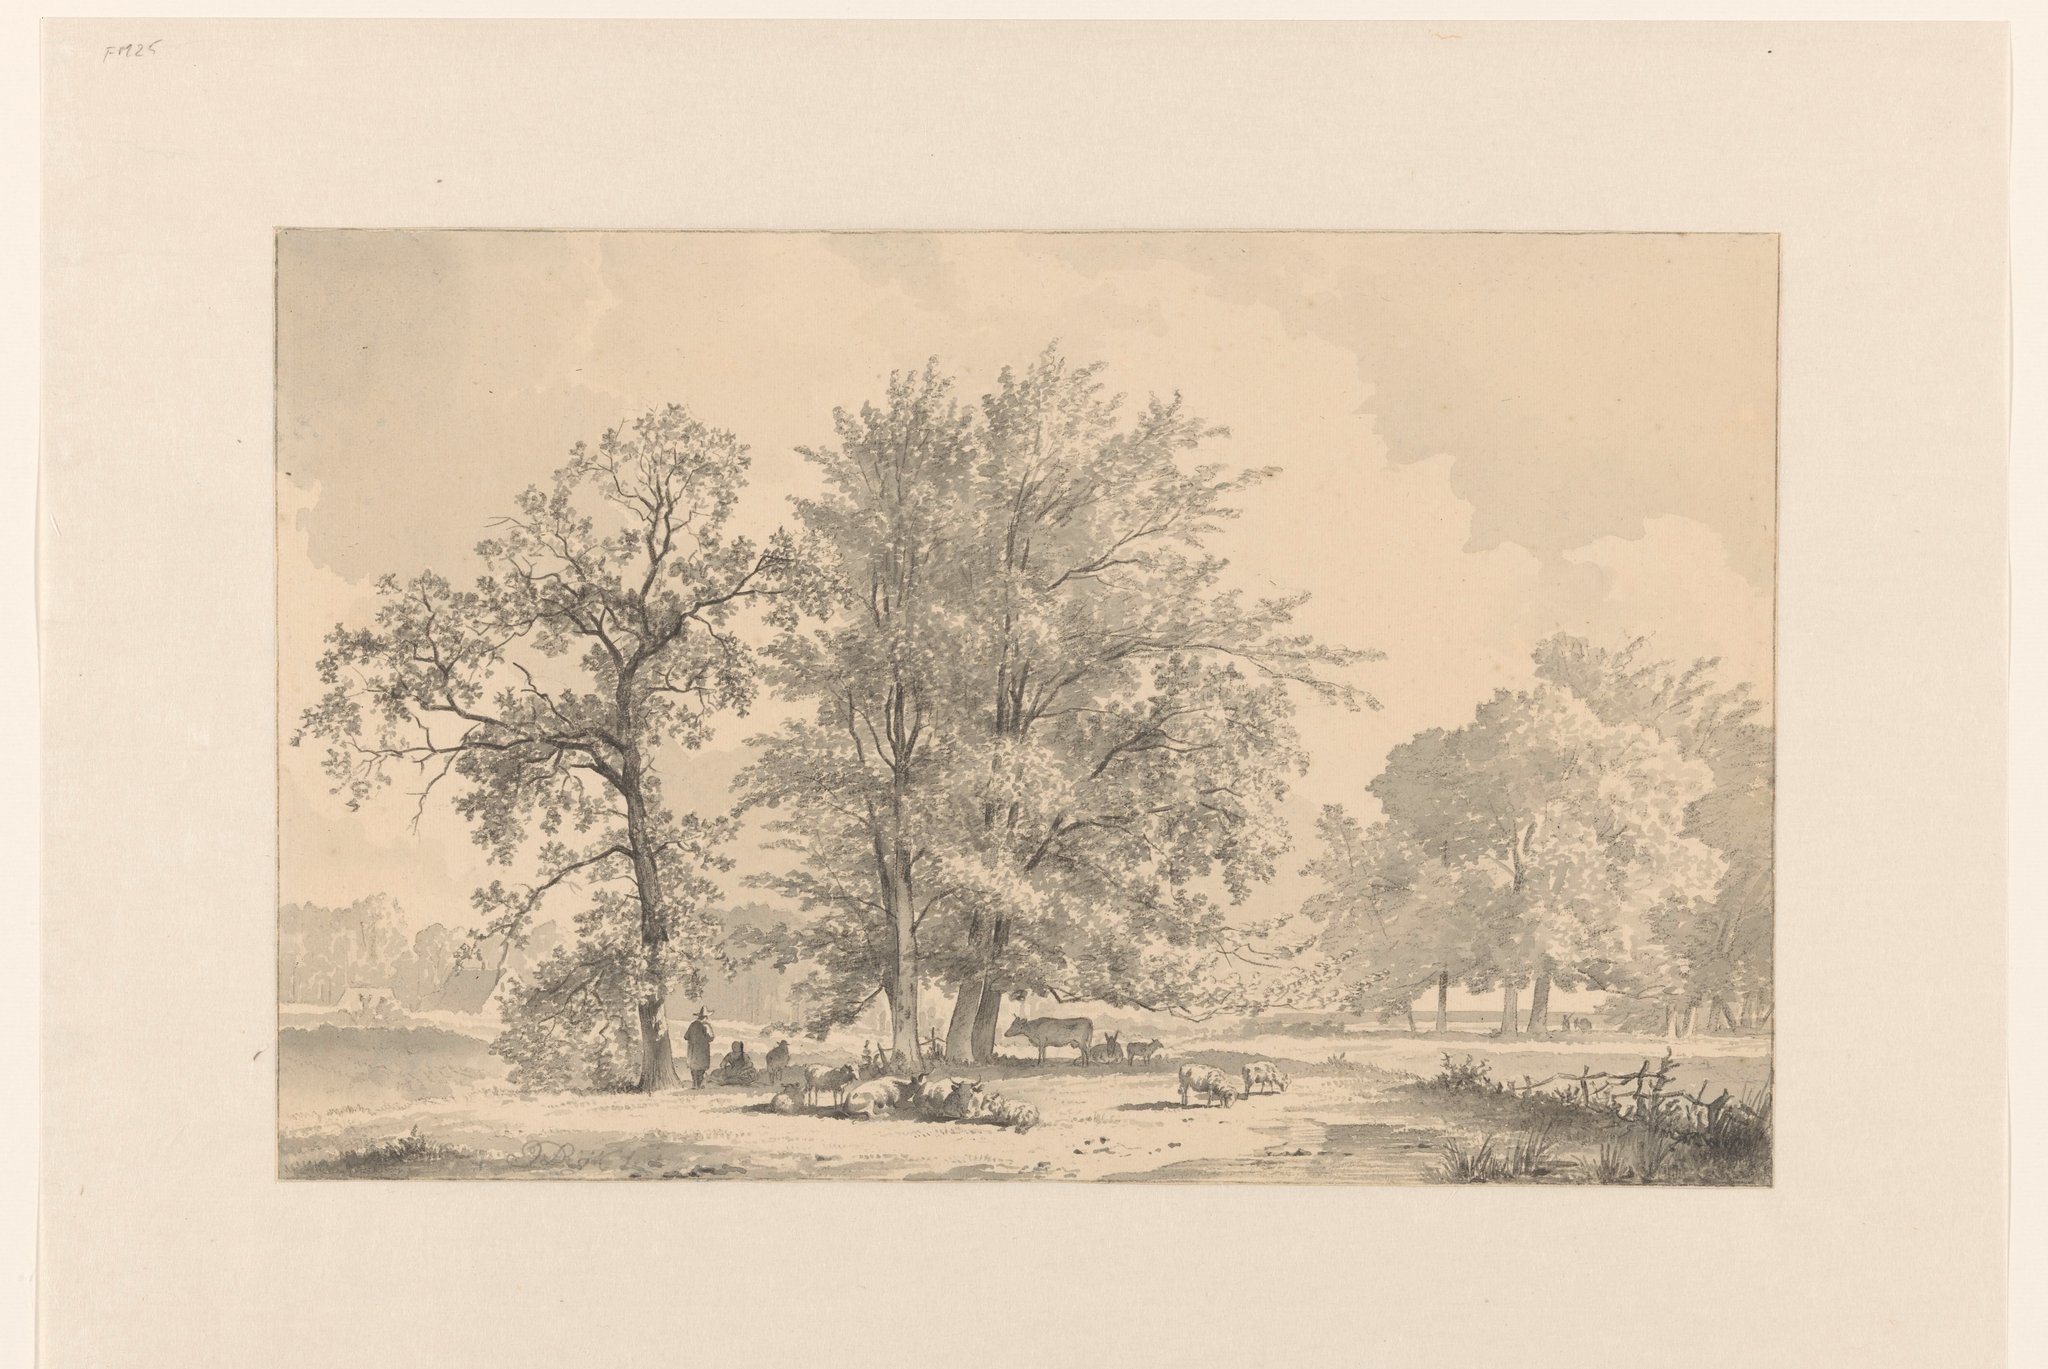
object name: drawing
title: Landschap met herders en vee onder grote bomen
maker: james de rijk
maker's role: draughtsman, painter, print maker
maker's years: 1806-1882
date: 1816-1882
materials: chalk, paper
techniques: brush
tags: landscapes in the temperate zone